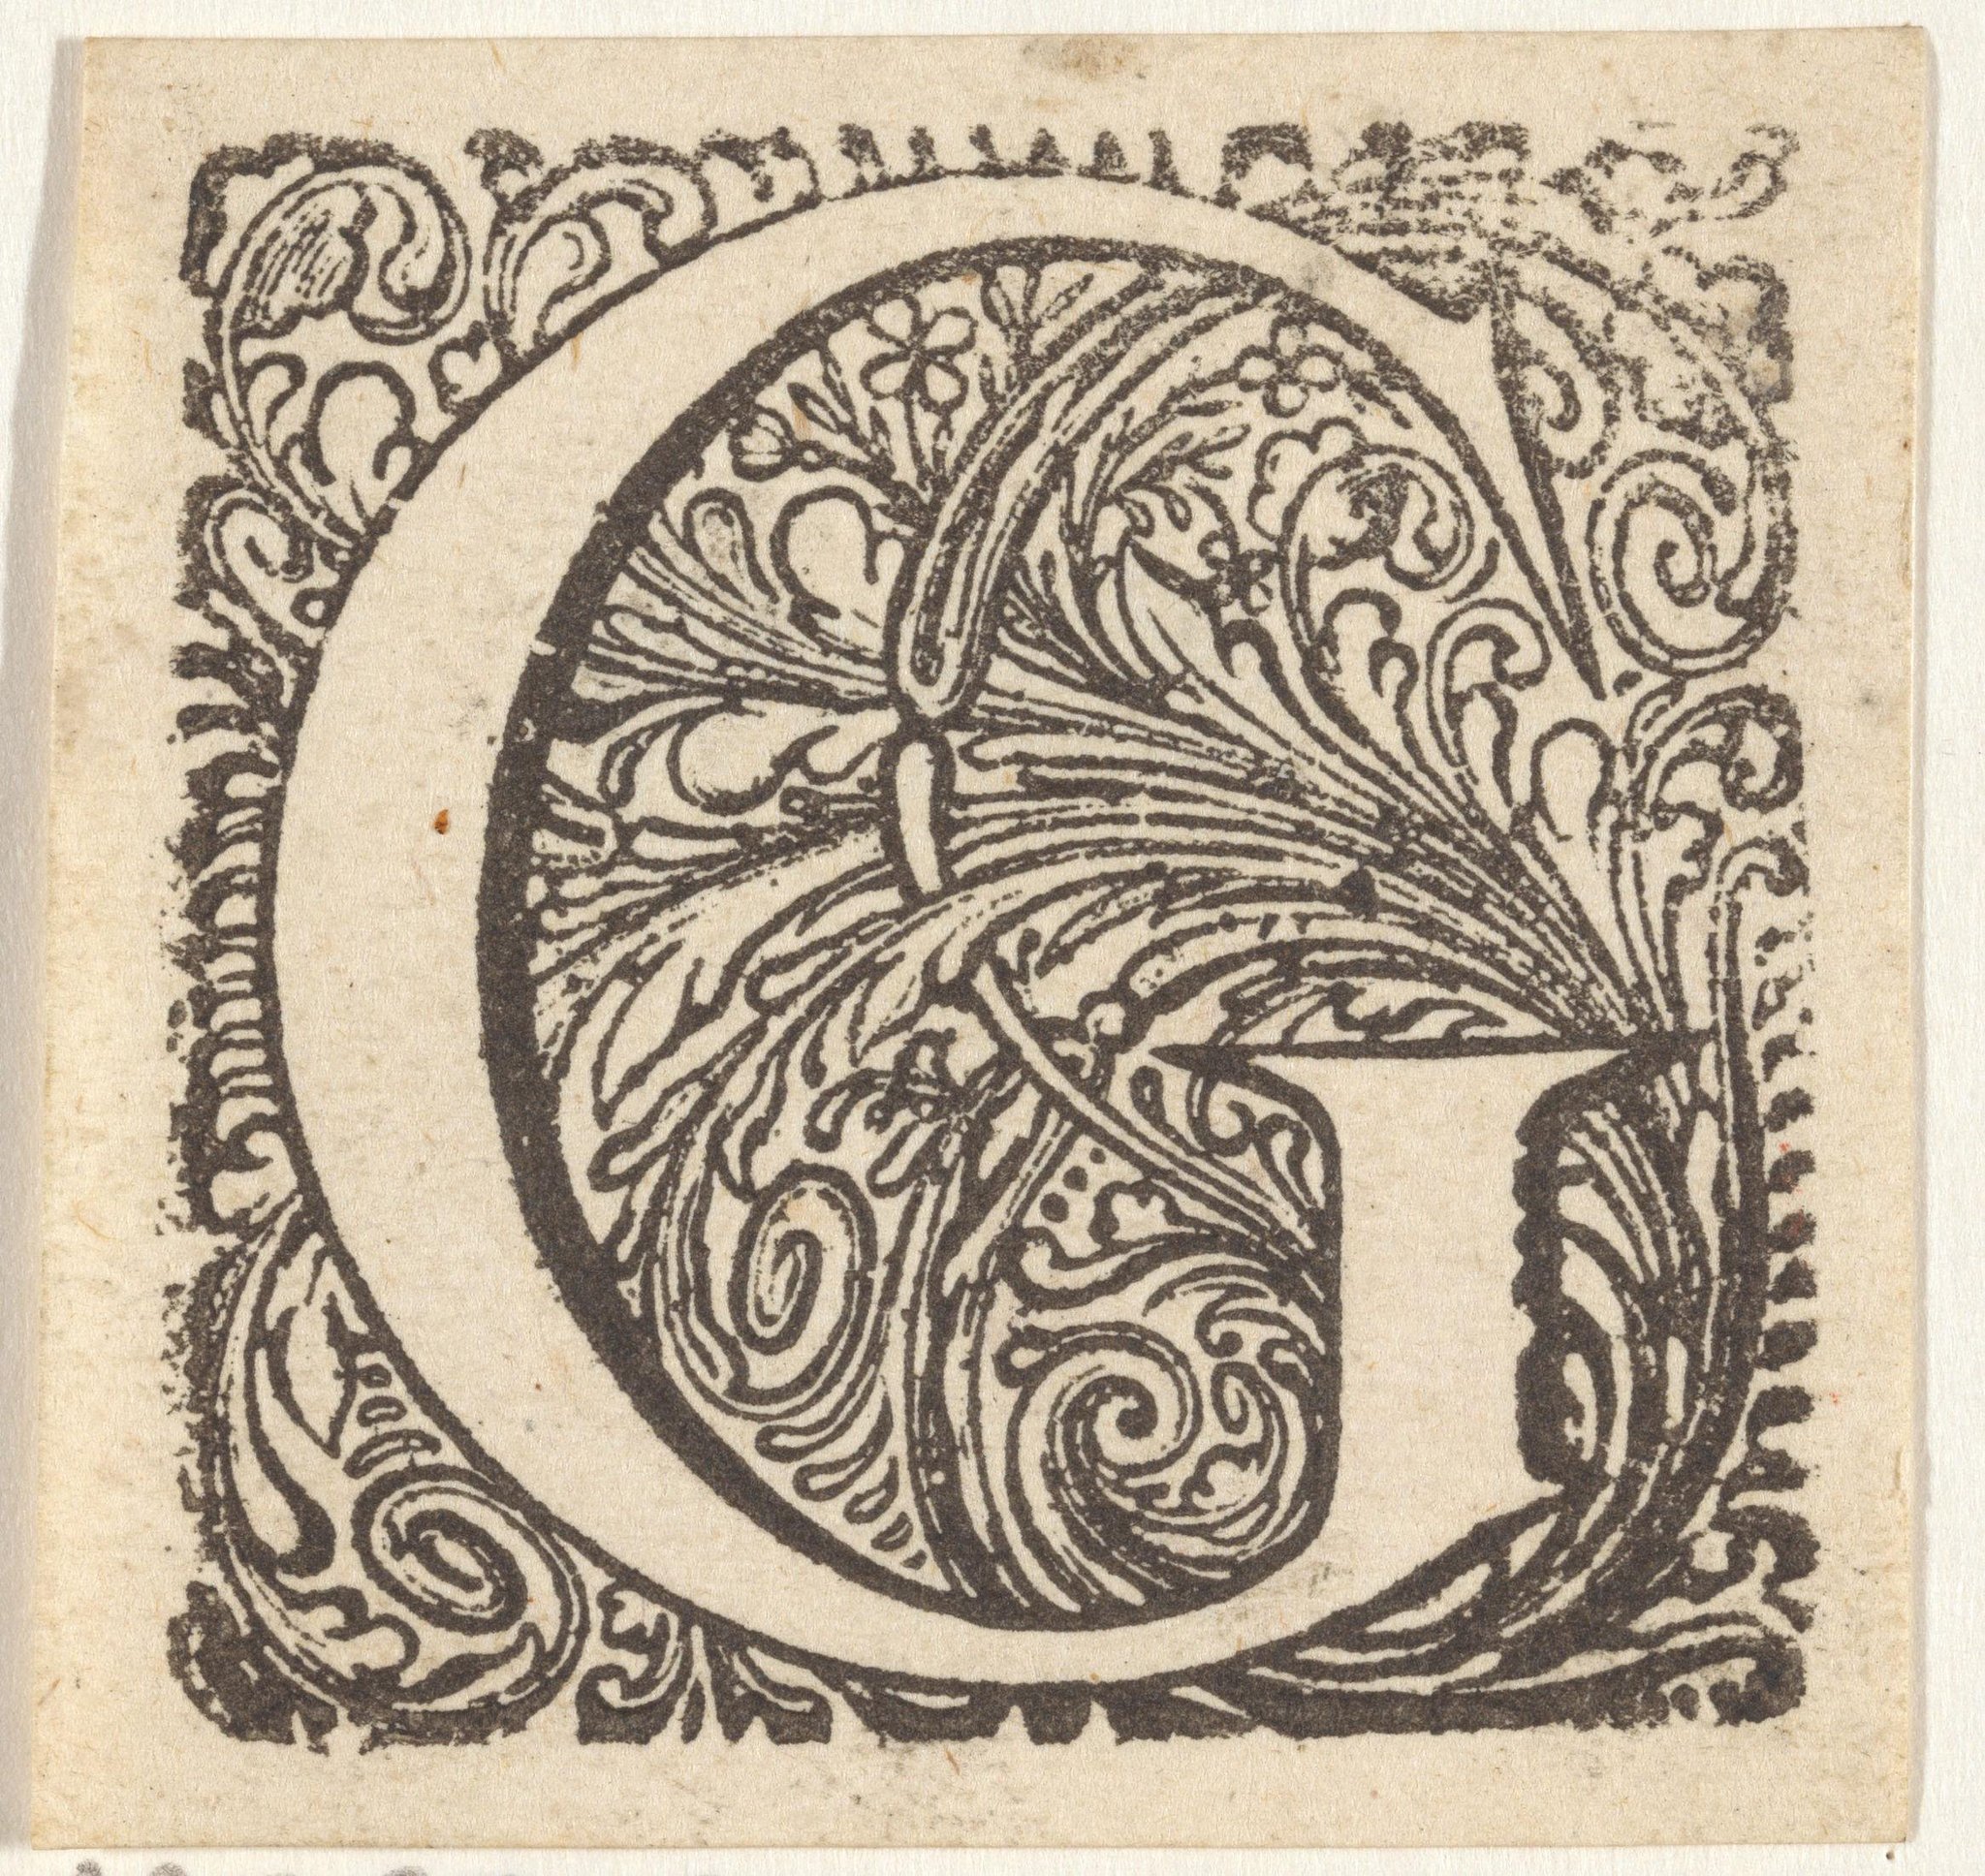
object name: print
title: Letter G in een geornamenteerde omlijsting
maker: Anonymous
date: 1600-1699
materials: paper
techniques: woodcut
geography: netherlands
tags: fancy letters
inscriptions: collector's mark: Lugt 240